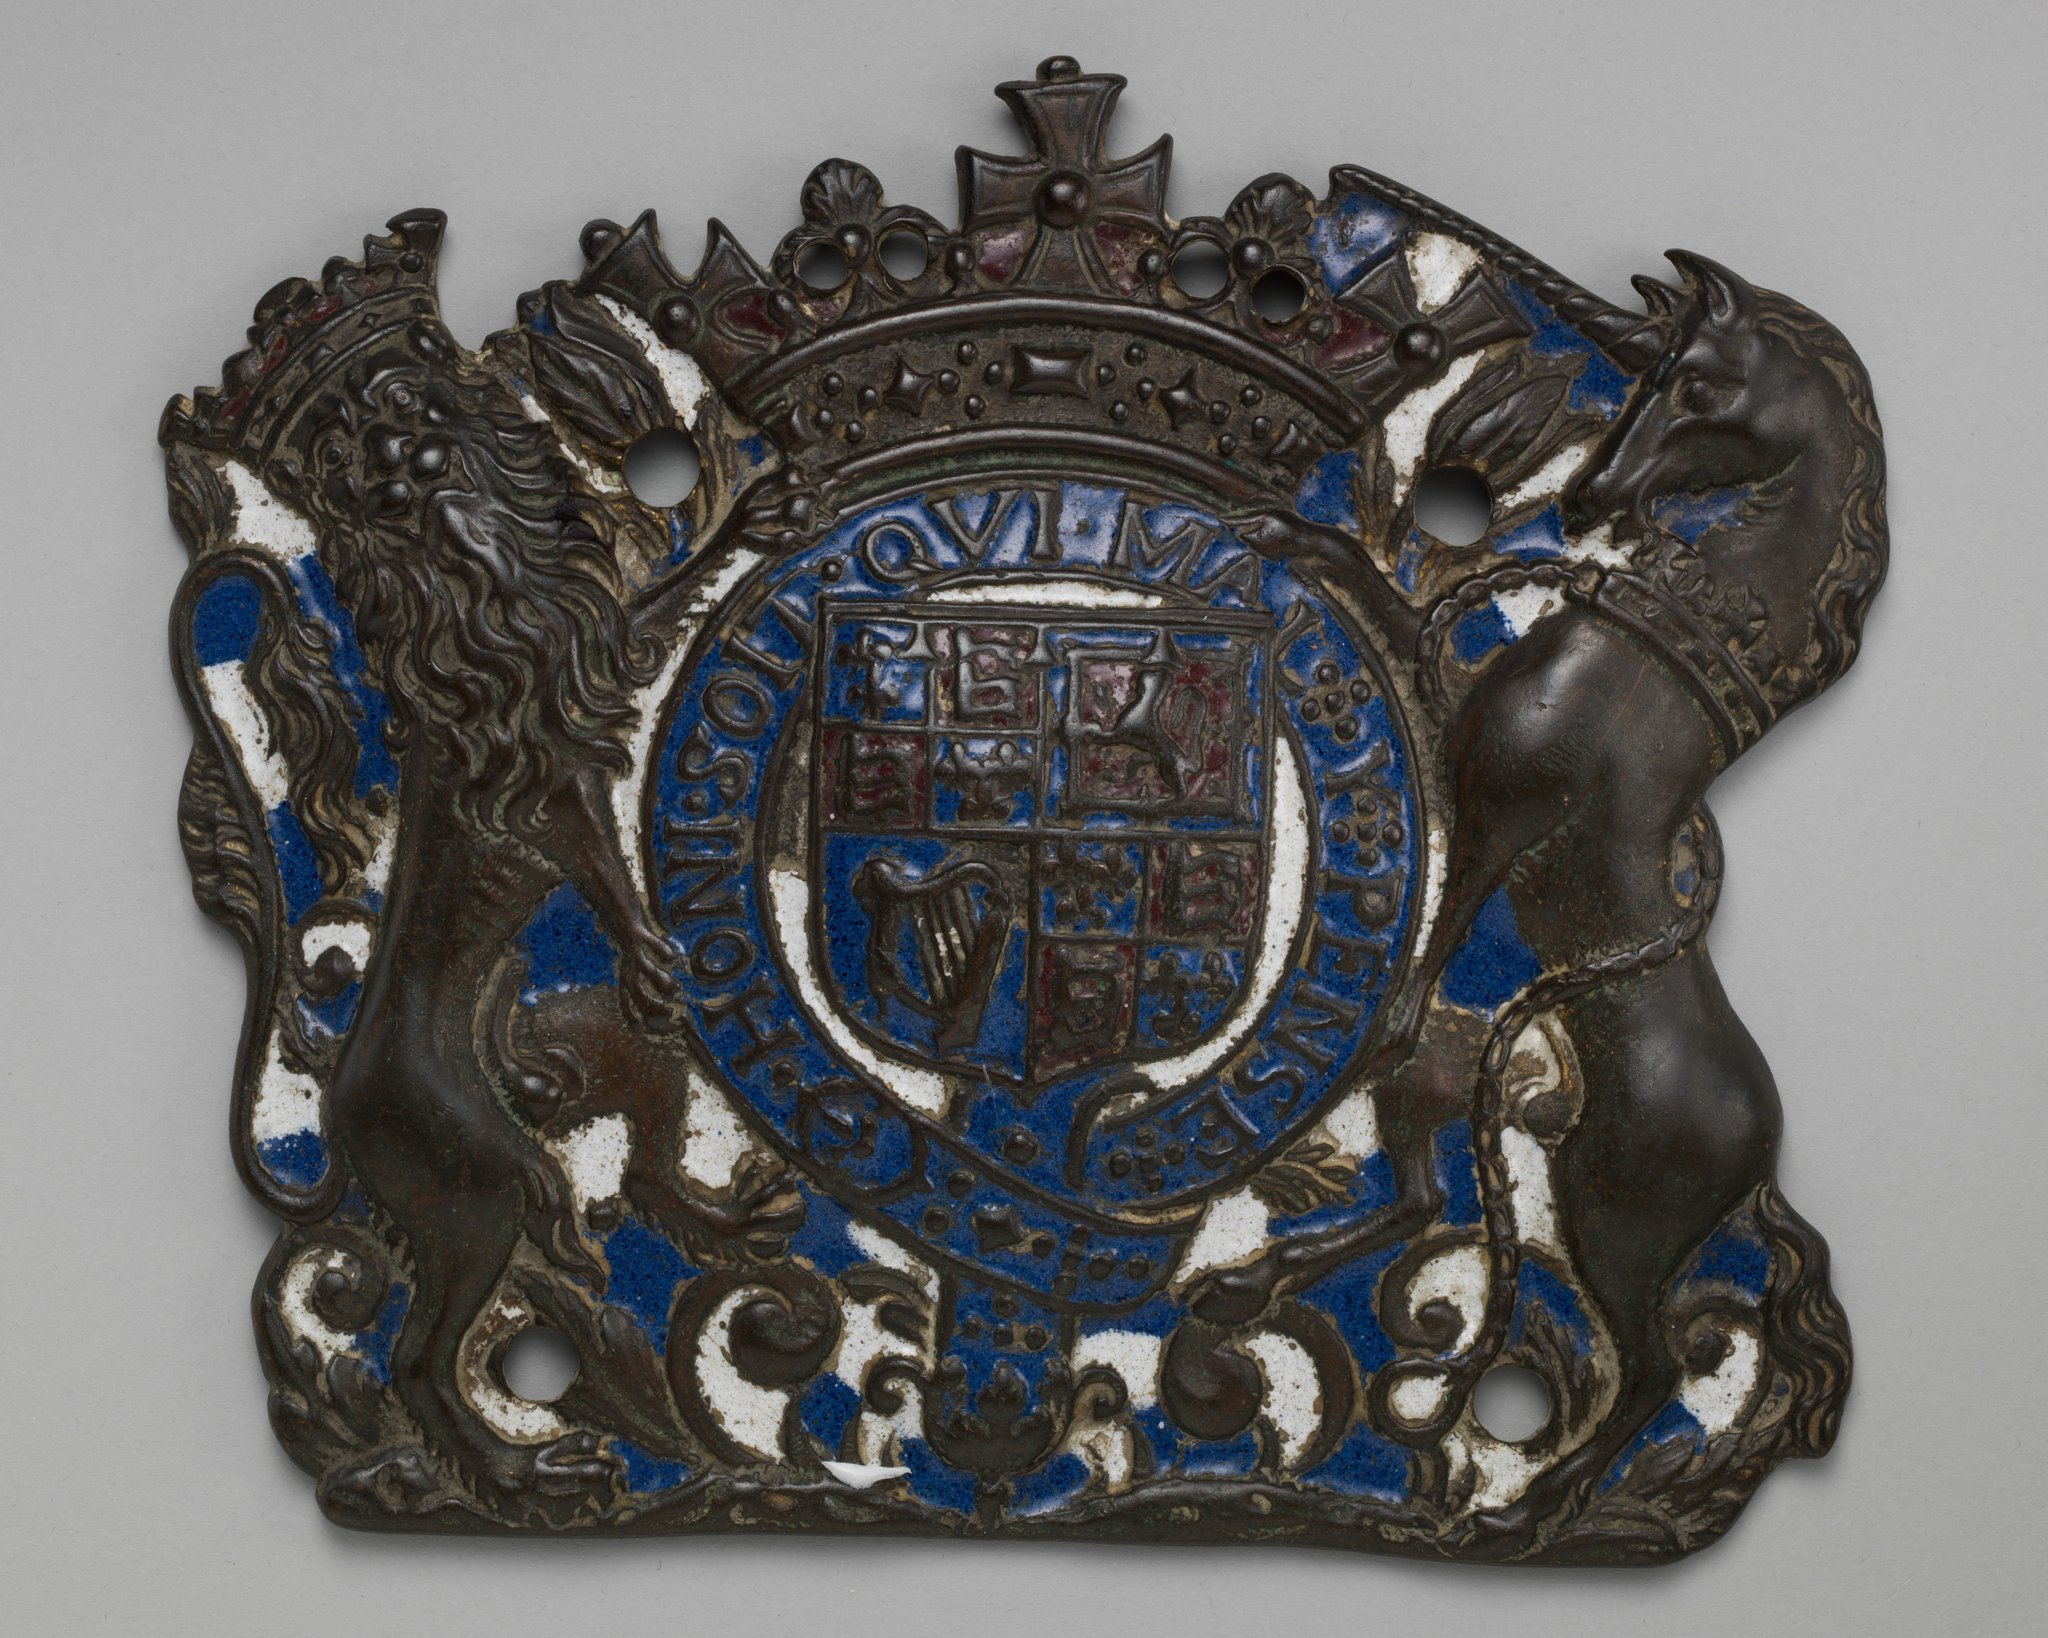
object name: armorial plaque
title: Armorial plaque of Charles II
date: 1666-1699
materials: brass, enamel